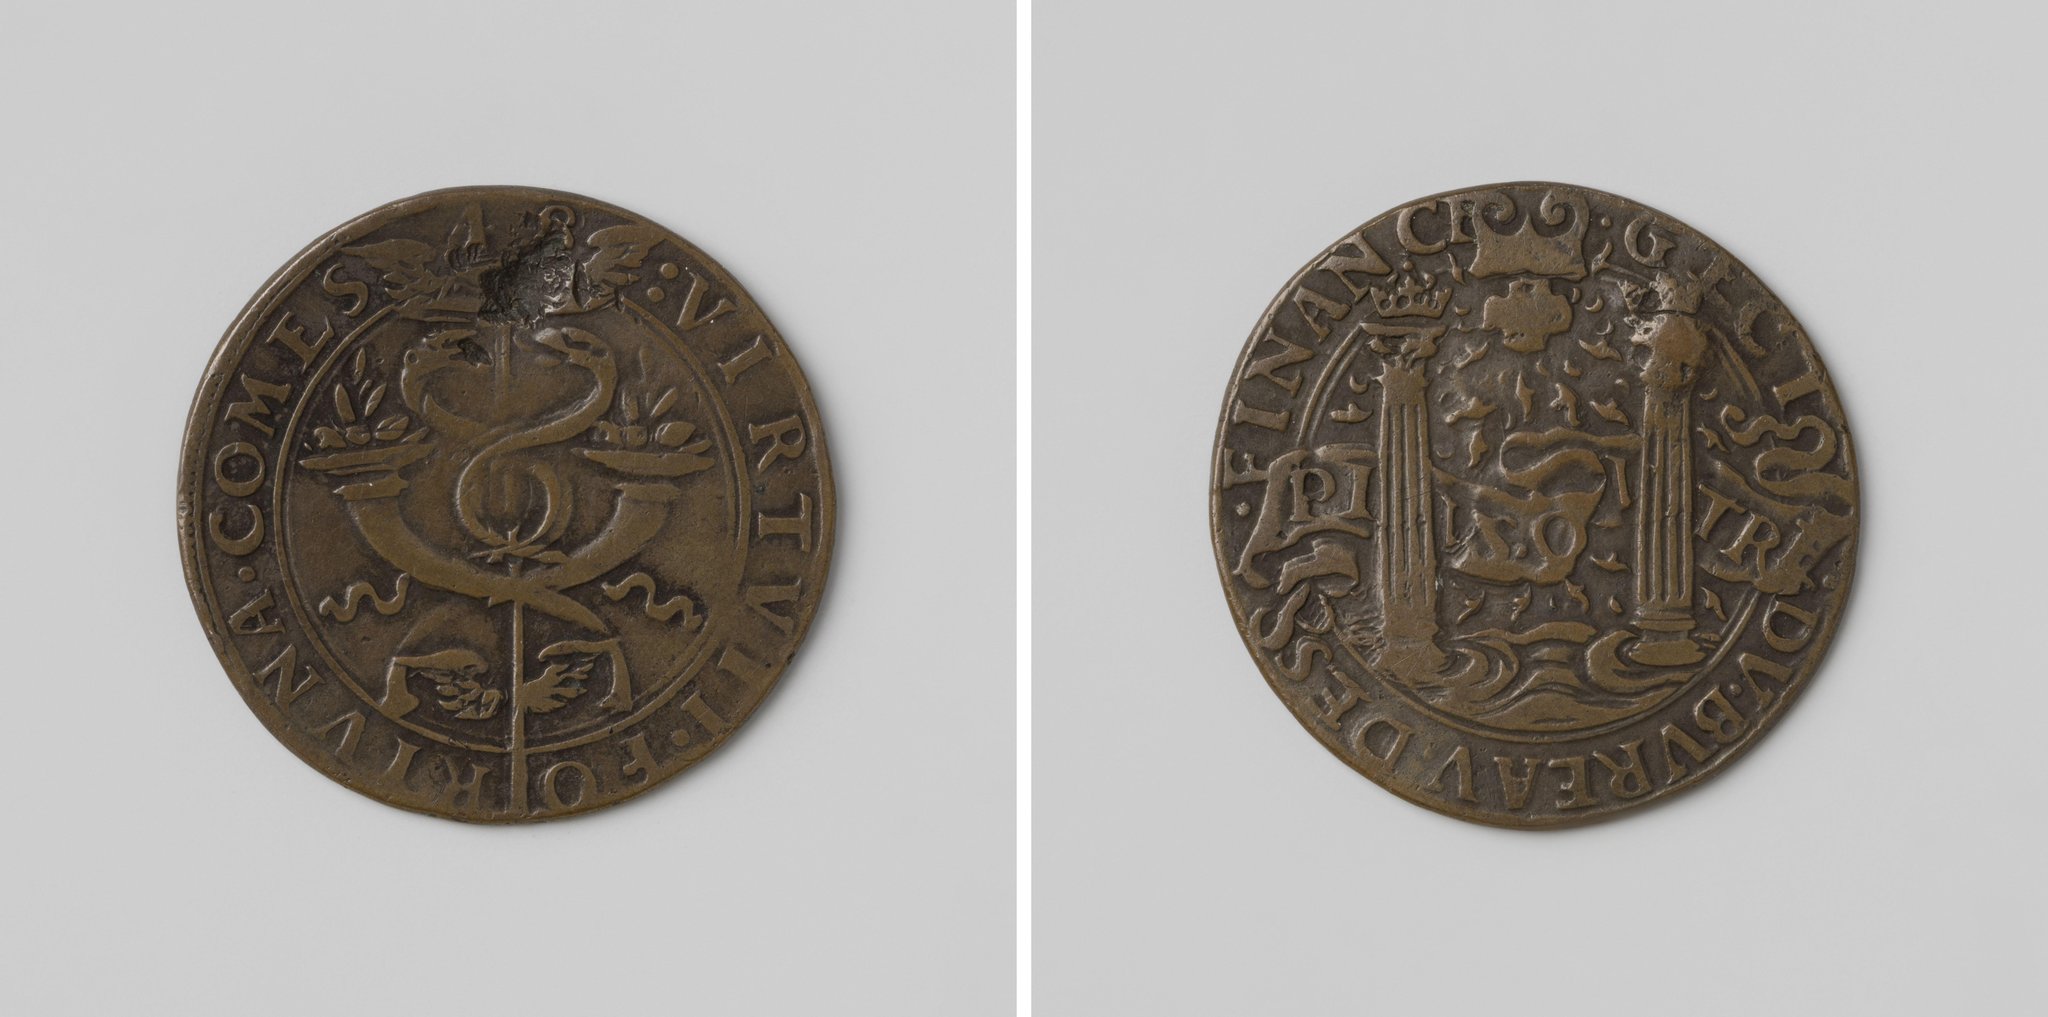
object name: jeton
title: Terugkeer van Karel V, Duits keizer in de Nederlanden, rekenpenning van de raad van Financiën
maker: Anonymous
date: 1548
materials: copper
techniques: striking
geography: netherlands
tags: ghent, charles v (holy roman emperor and king of spain), low countries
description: Koperen penning. Voorzijde: Mercuriusstaf, geflankeerd door twee gevulde hoorns van overvloed binnen omschrift. Keerzijde: wimpel met opschrift onder vuurslag en vuursteen met vonken tussen zuilen van Herkules binnen omschrift